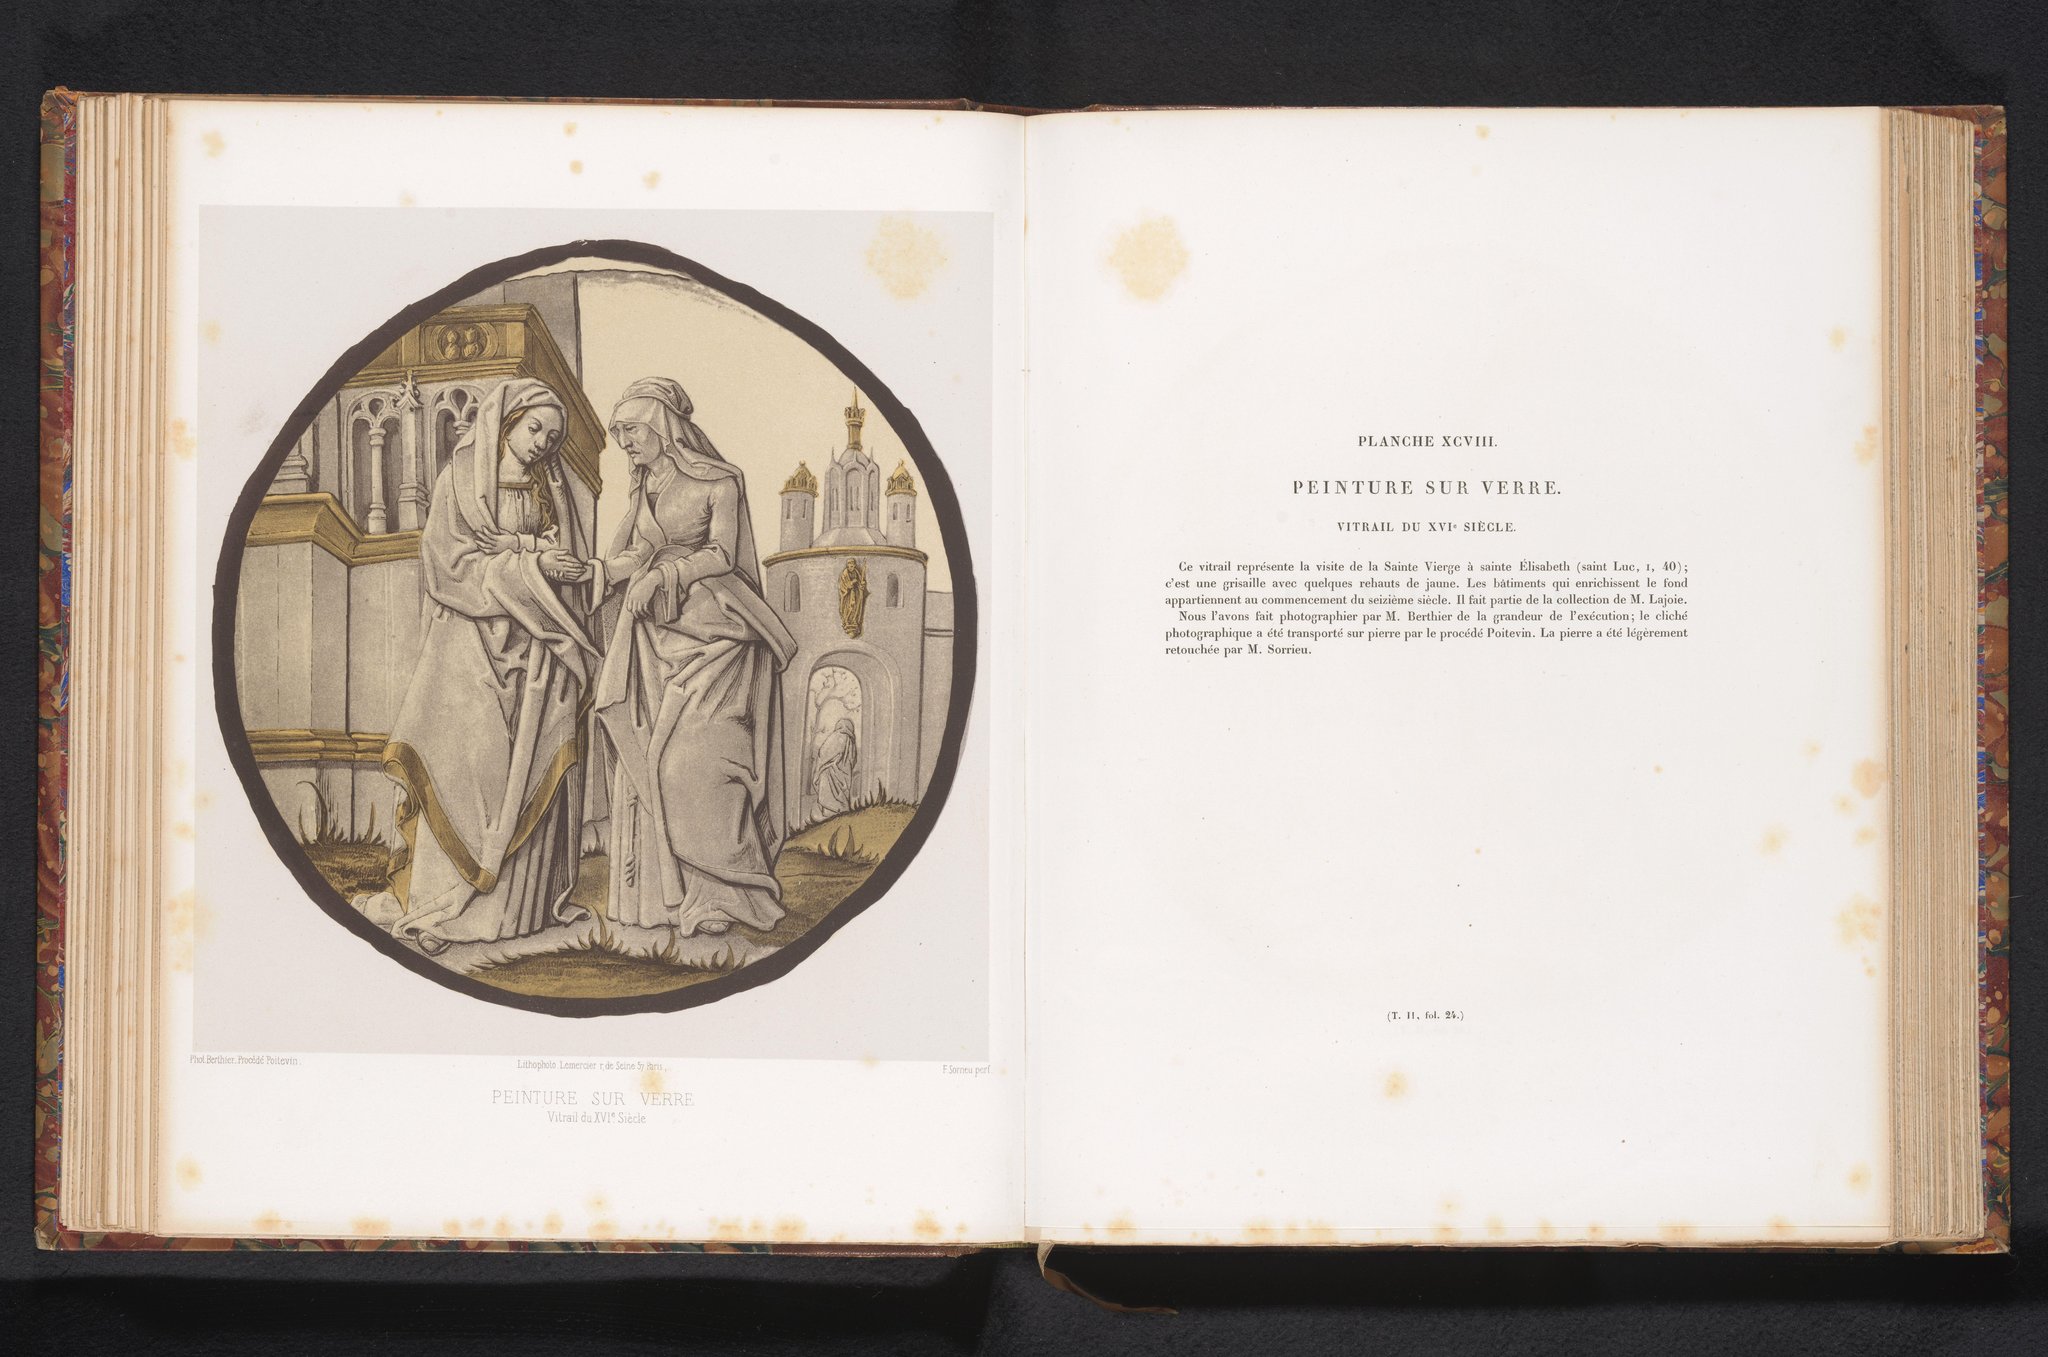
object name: photomechanical print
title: Vitrail du XVIe Siècle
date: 1859-1864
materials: paper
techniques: photolithography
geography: paris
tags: mary and elisabeth shaking hands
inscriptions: name: ‘Phot. Berthier. Procéde Poitevin/ F. Sorrieu perf.’